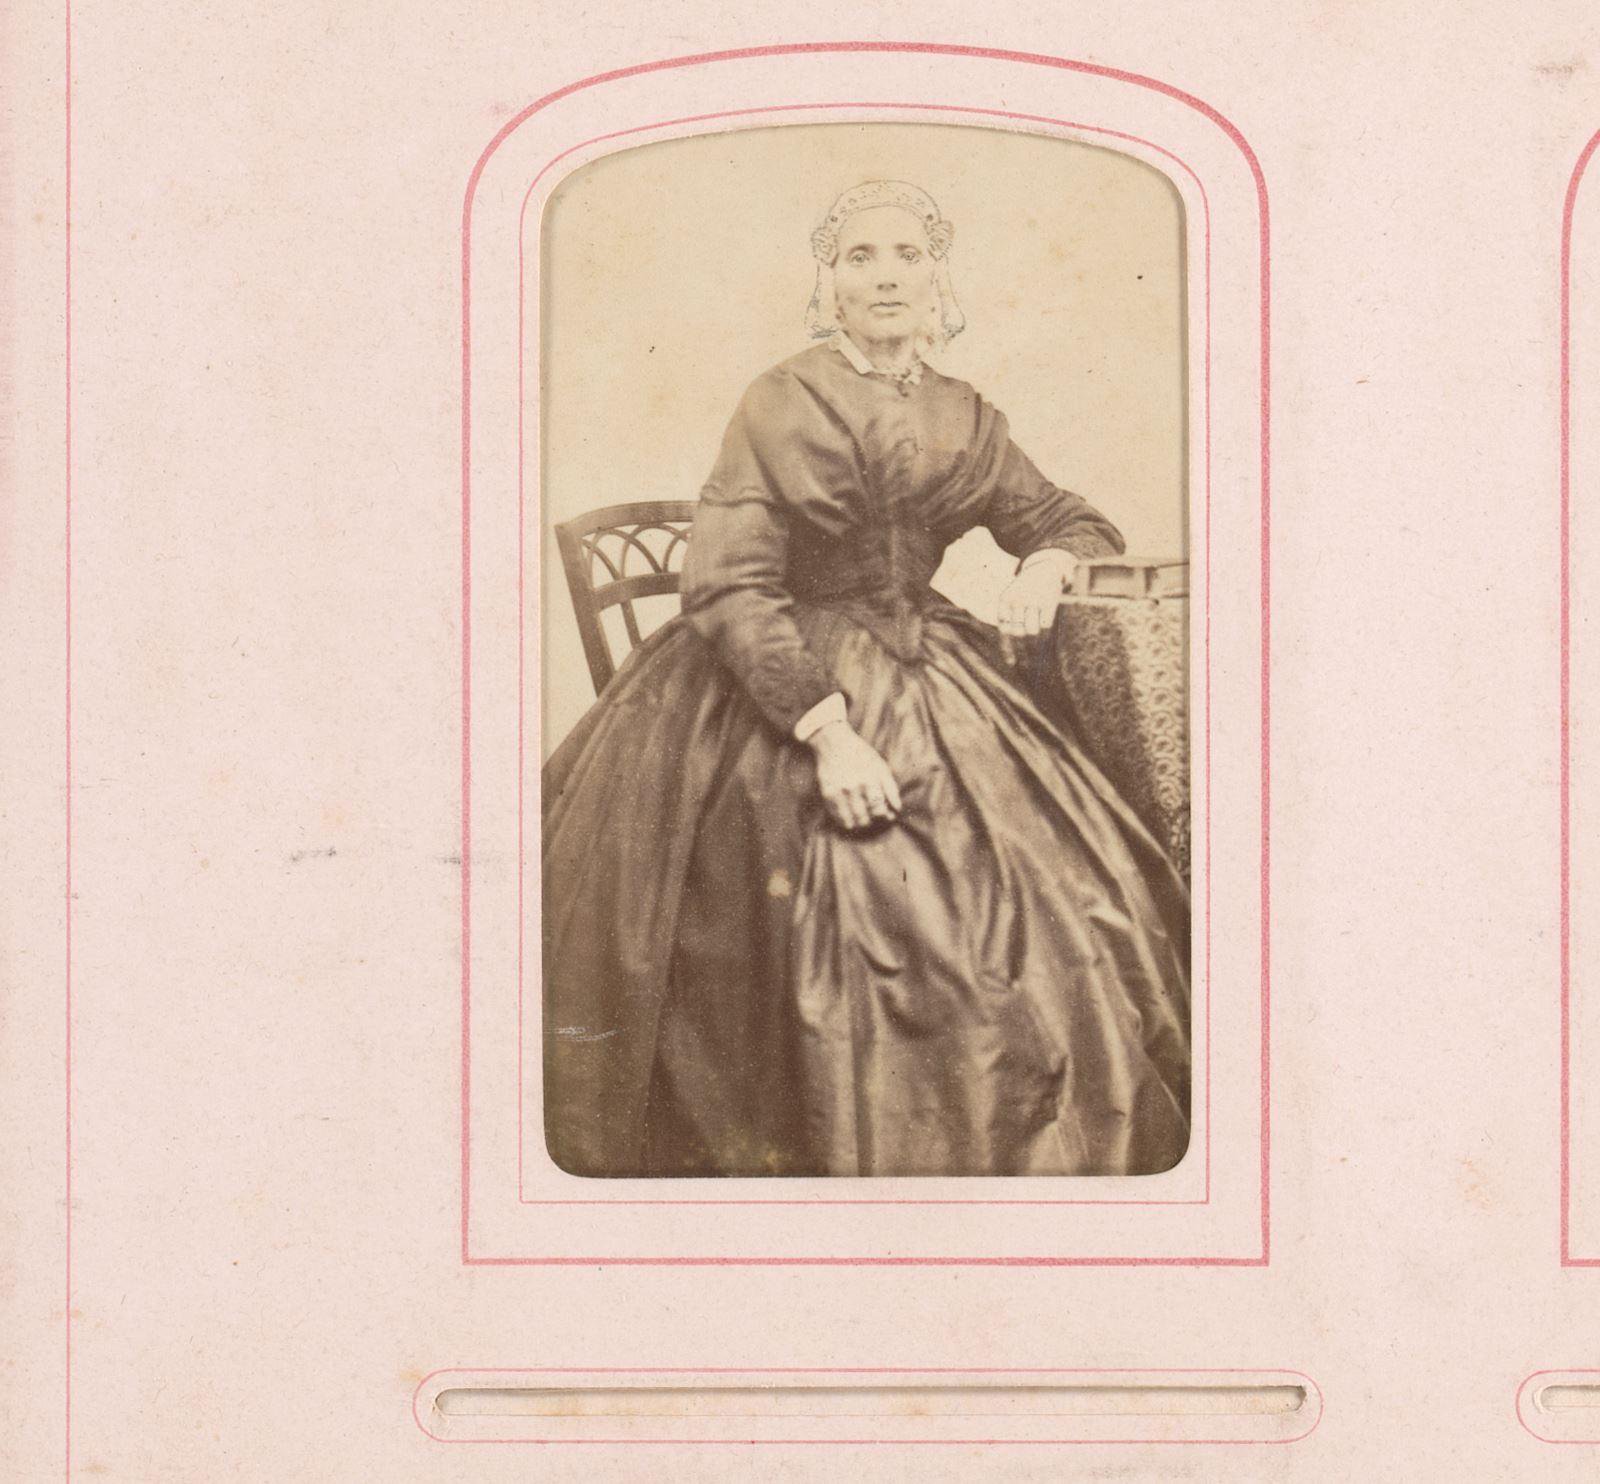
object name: carte de visite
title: Nederland, portret zittende vrouw met witte ingetekende klederdrachtmuts, Boukje de Groot-Mulder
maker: Anonymous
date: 1855-1885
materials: cardboard, paper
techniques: albumen print, drawing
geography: netherlands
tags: adult woman, historical persons, folk costume, regional costume, netherlands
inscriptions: inscription: ‘Boukje Mulder/ getr met/ Klaas de Groot’